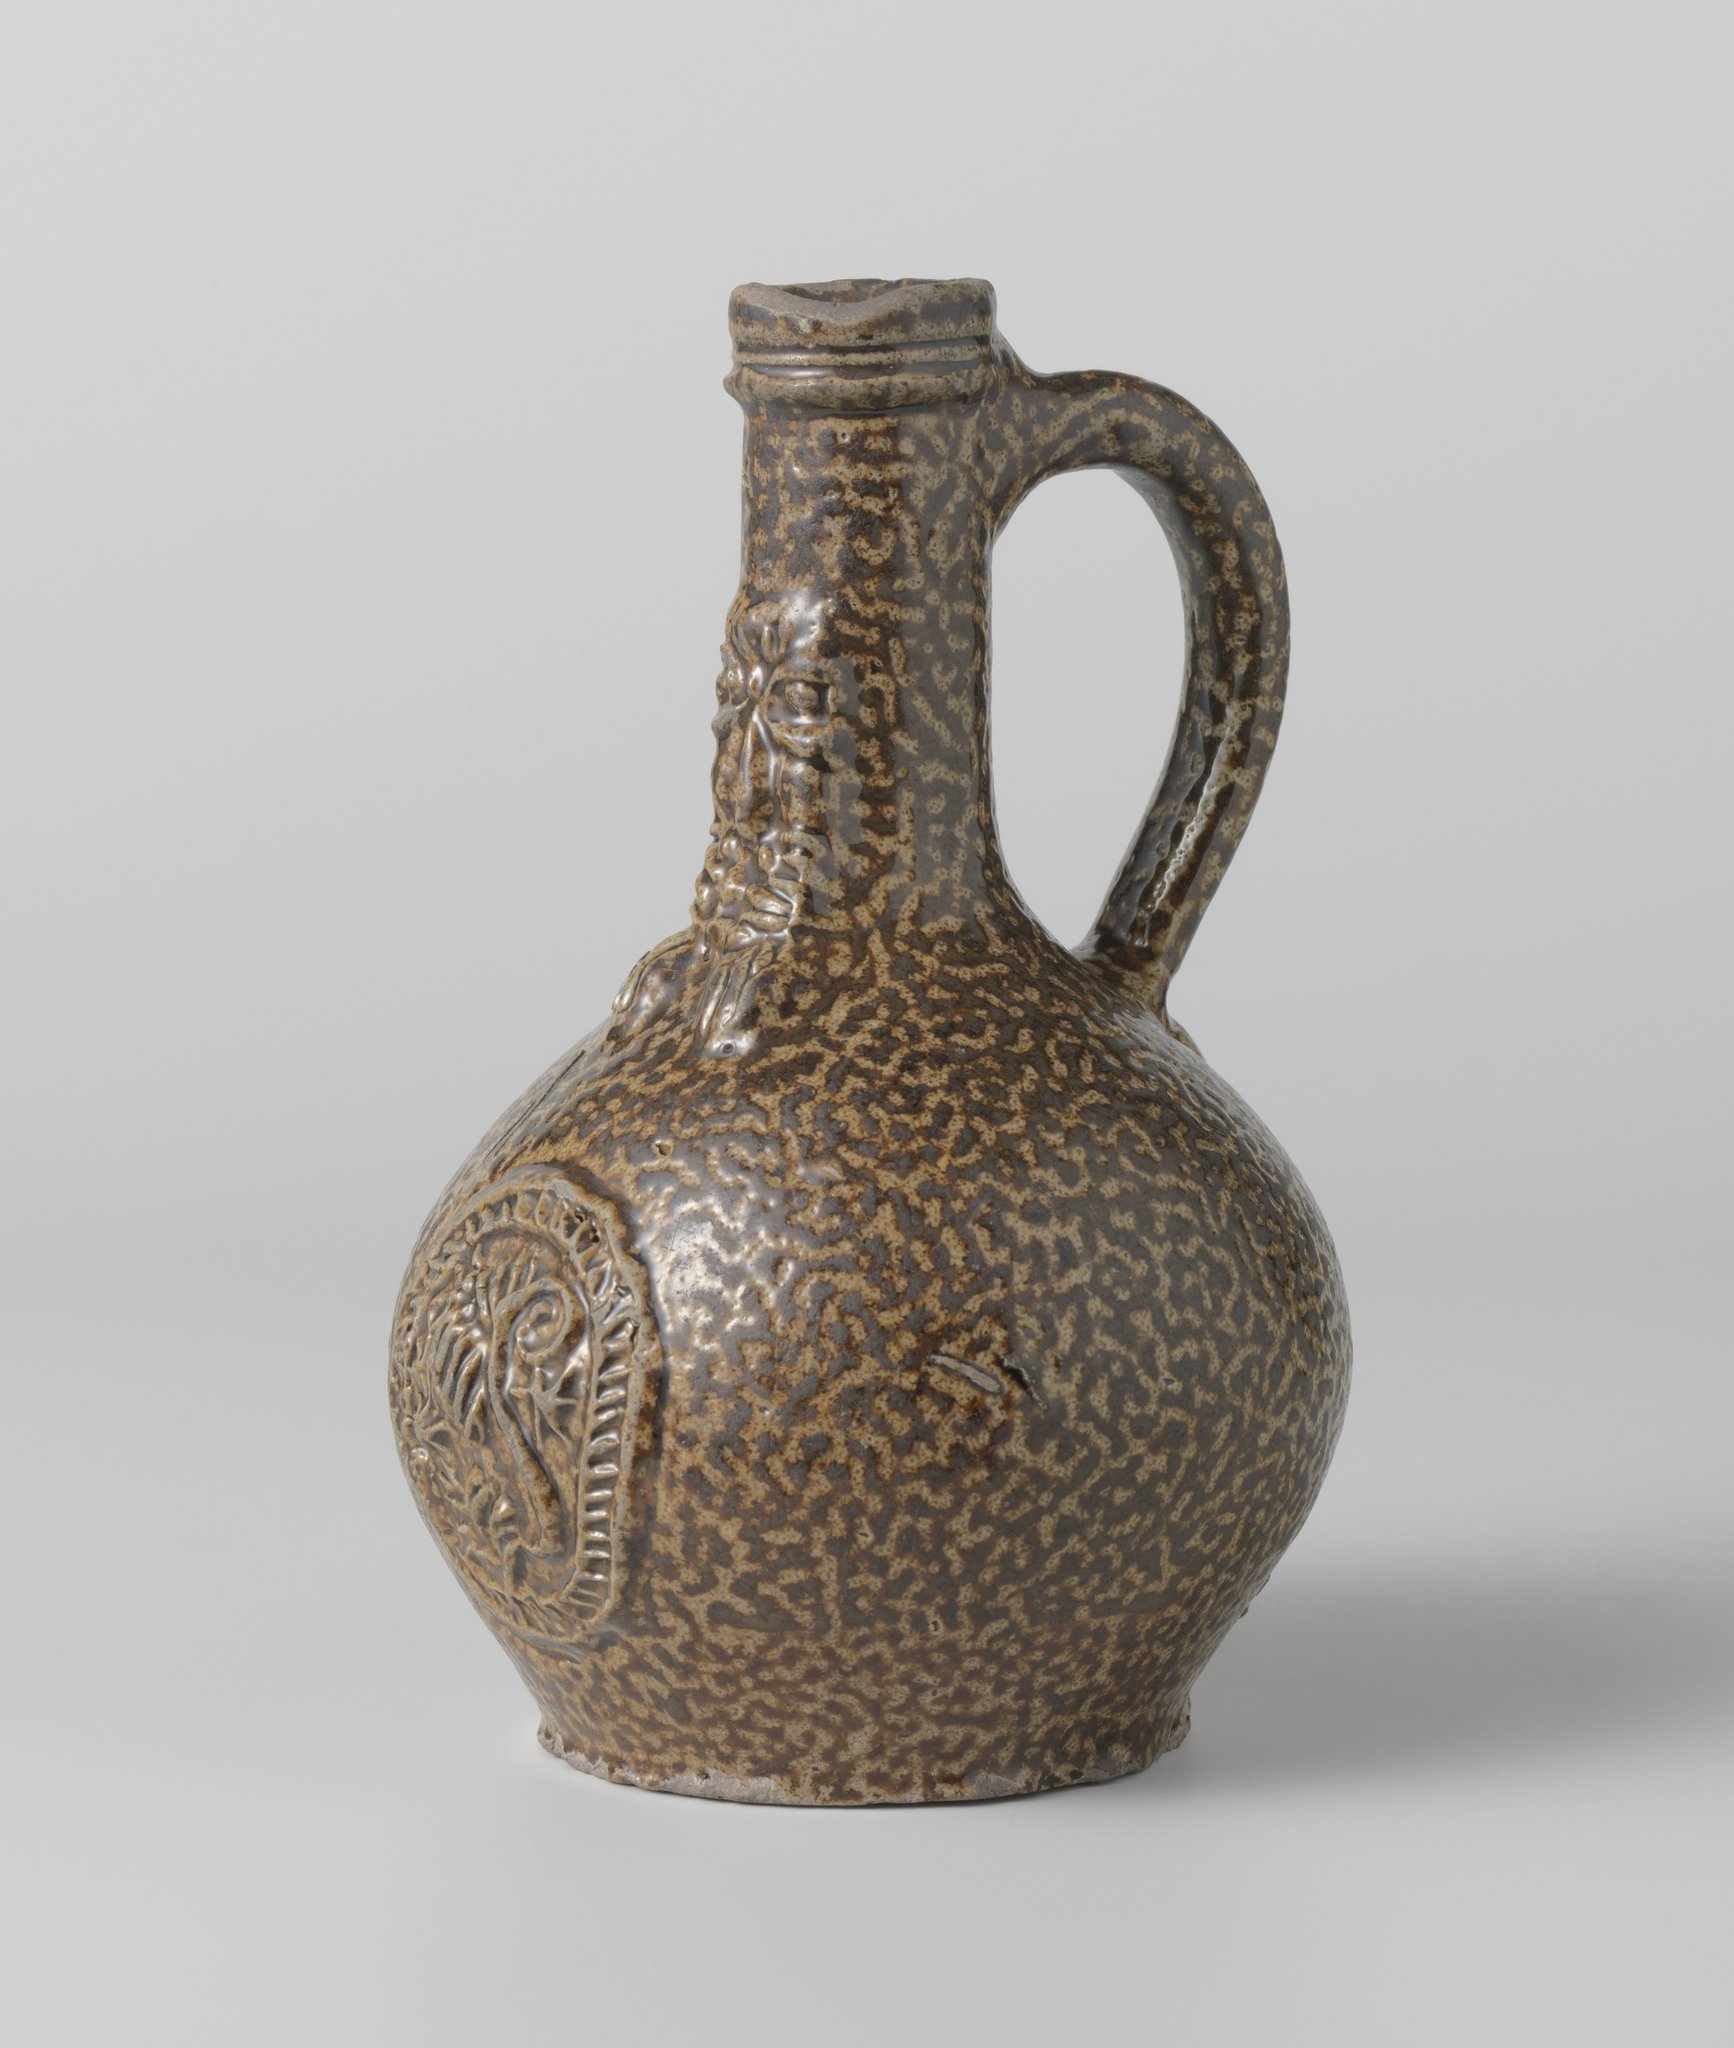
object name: jug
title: Jug (Bartmann jug) with a lion in a medallion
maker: Anonymous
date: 1700-1799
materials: engobe, glaze, stoneware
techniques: firing, forming, relief, turning, vitrification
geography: frechen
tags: beard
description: Kruik (baardmankruik) op standvlak met een bolvormig lichaam en smalle, lange nek. Het C-vormige oor is bevestigd aan de nek en de schouder. Profiel op de nek. Bedekt met een bruine engobe. Op de buik in reliëf een gedrukt en opgelegd medaillon met een leeuw[?] tussen sterren. Op de nek, doorlopend op de schouder, een baardman. Frechen.